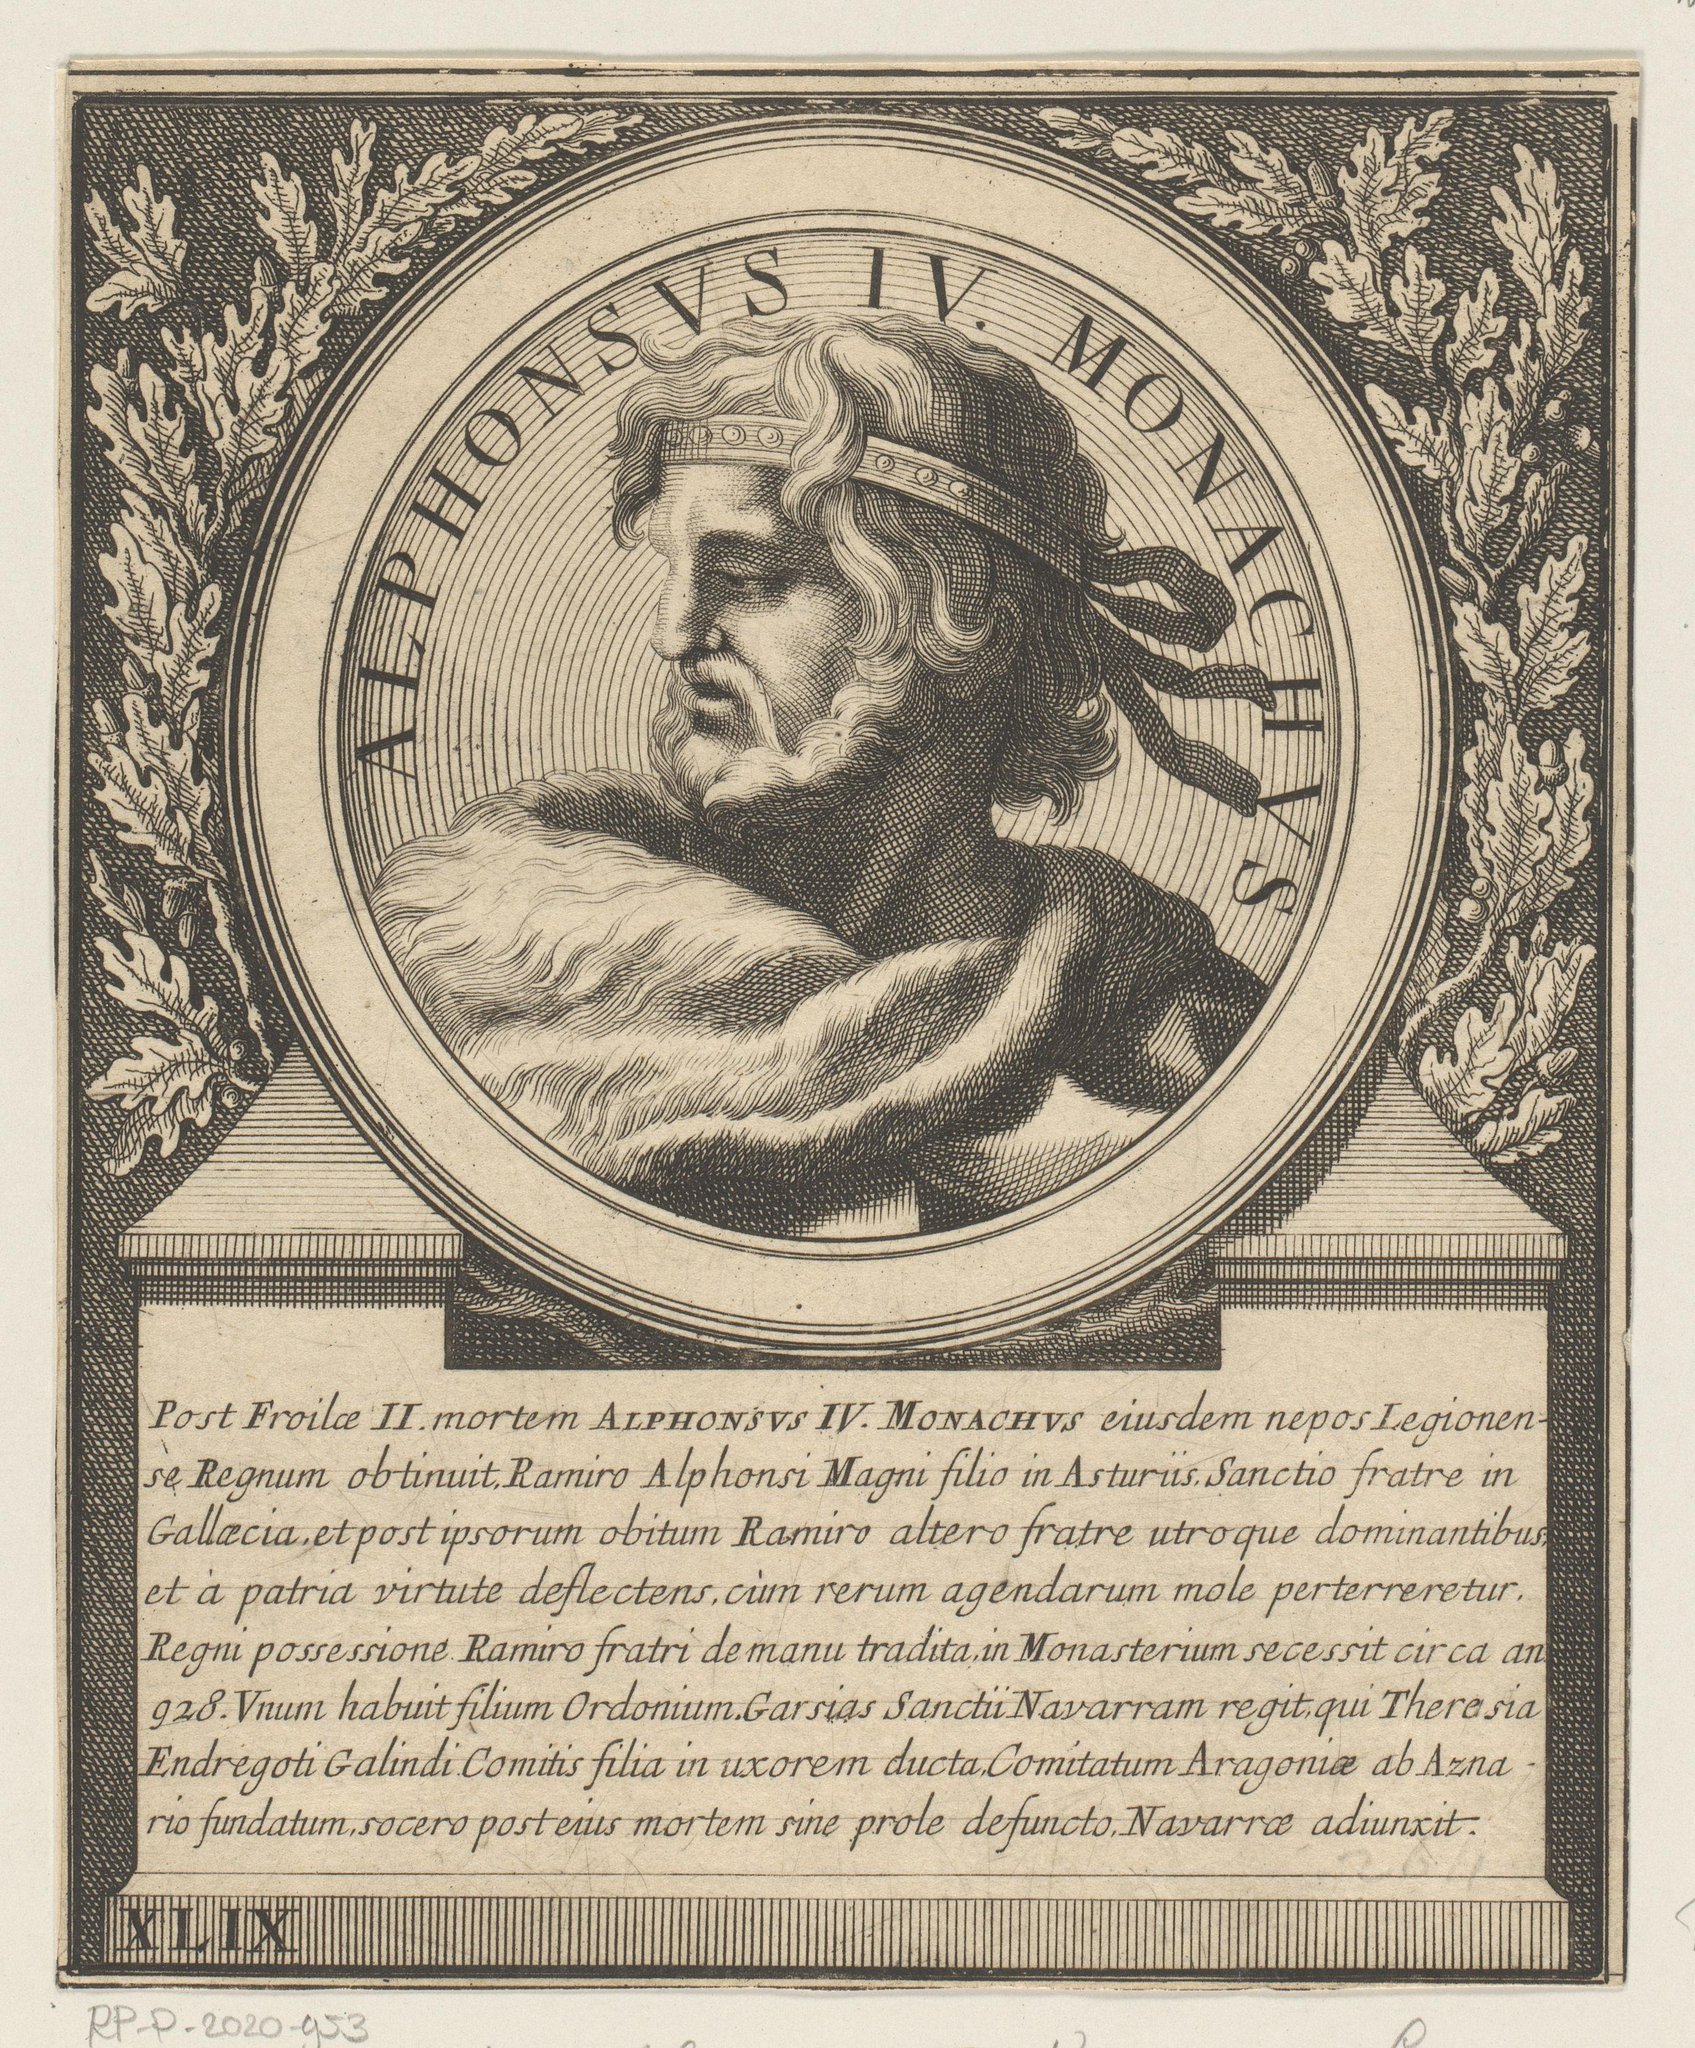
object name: print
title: Series Chronologica et Imagines Regum Hispaniae ab Ataulpho ad Carolum II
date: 1698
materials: paper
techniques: engraving, etching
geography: paris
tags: historical persons, ruler, sovereign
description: Portret afkomstig van een grote prent, getiteld 'Series Chronologica et Imagines Regum Hispaniae ab Ataulpho ad Carolum II', bestaande uit meerdere bladen die samengevoegd konden worden, uitgegeven door Petrus de la Tour in 1698.